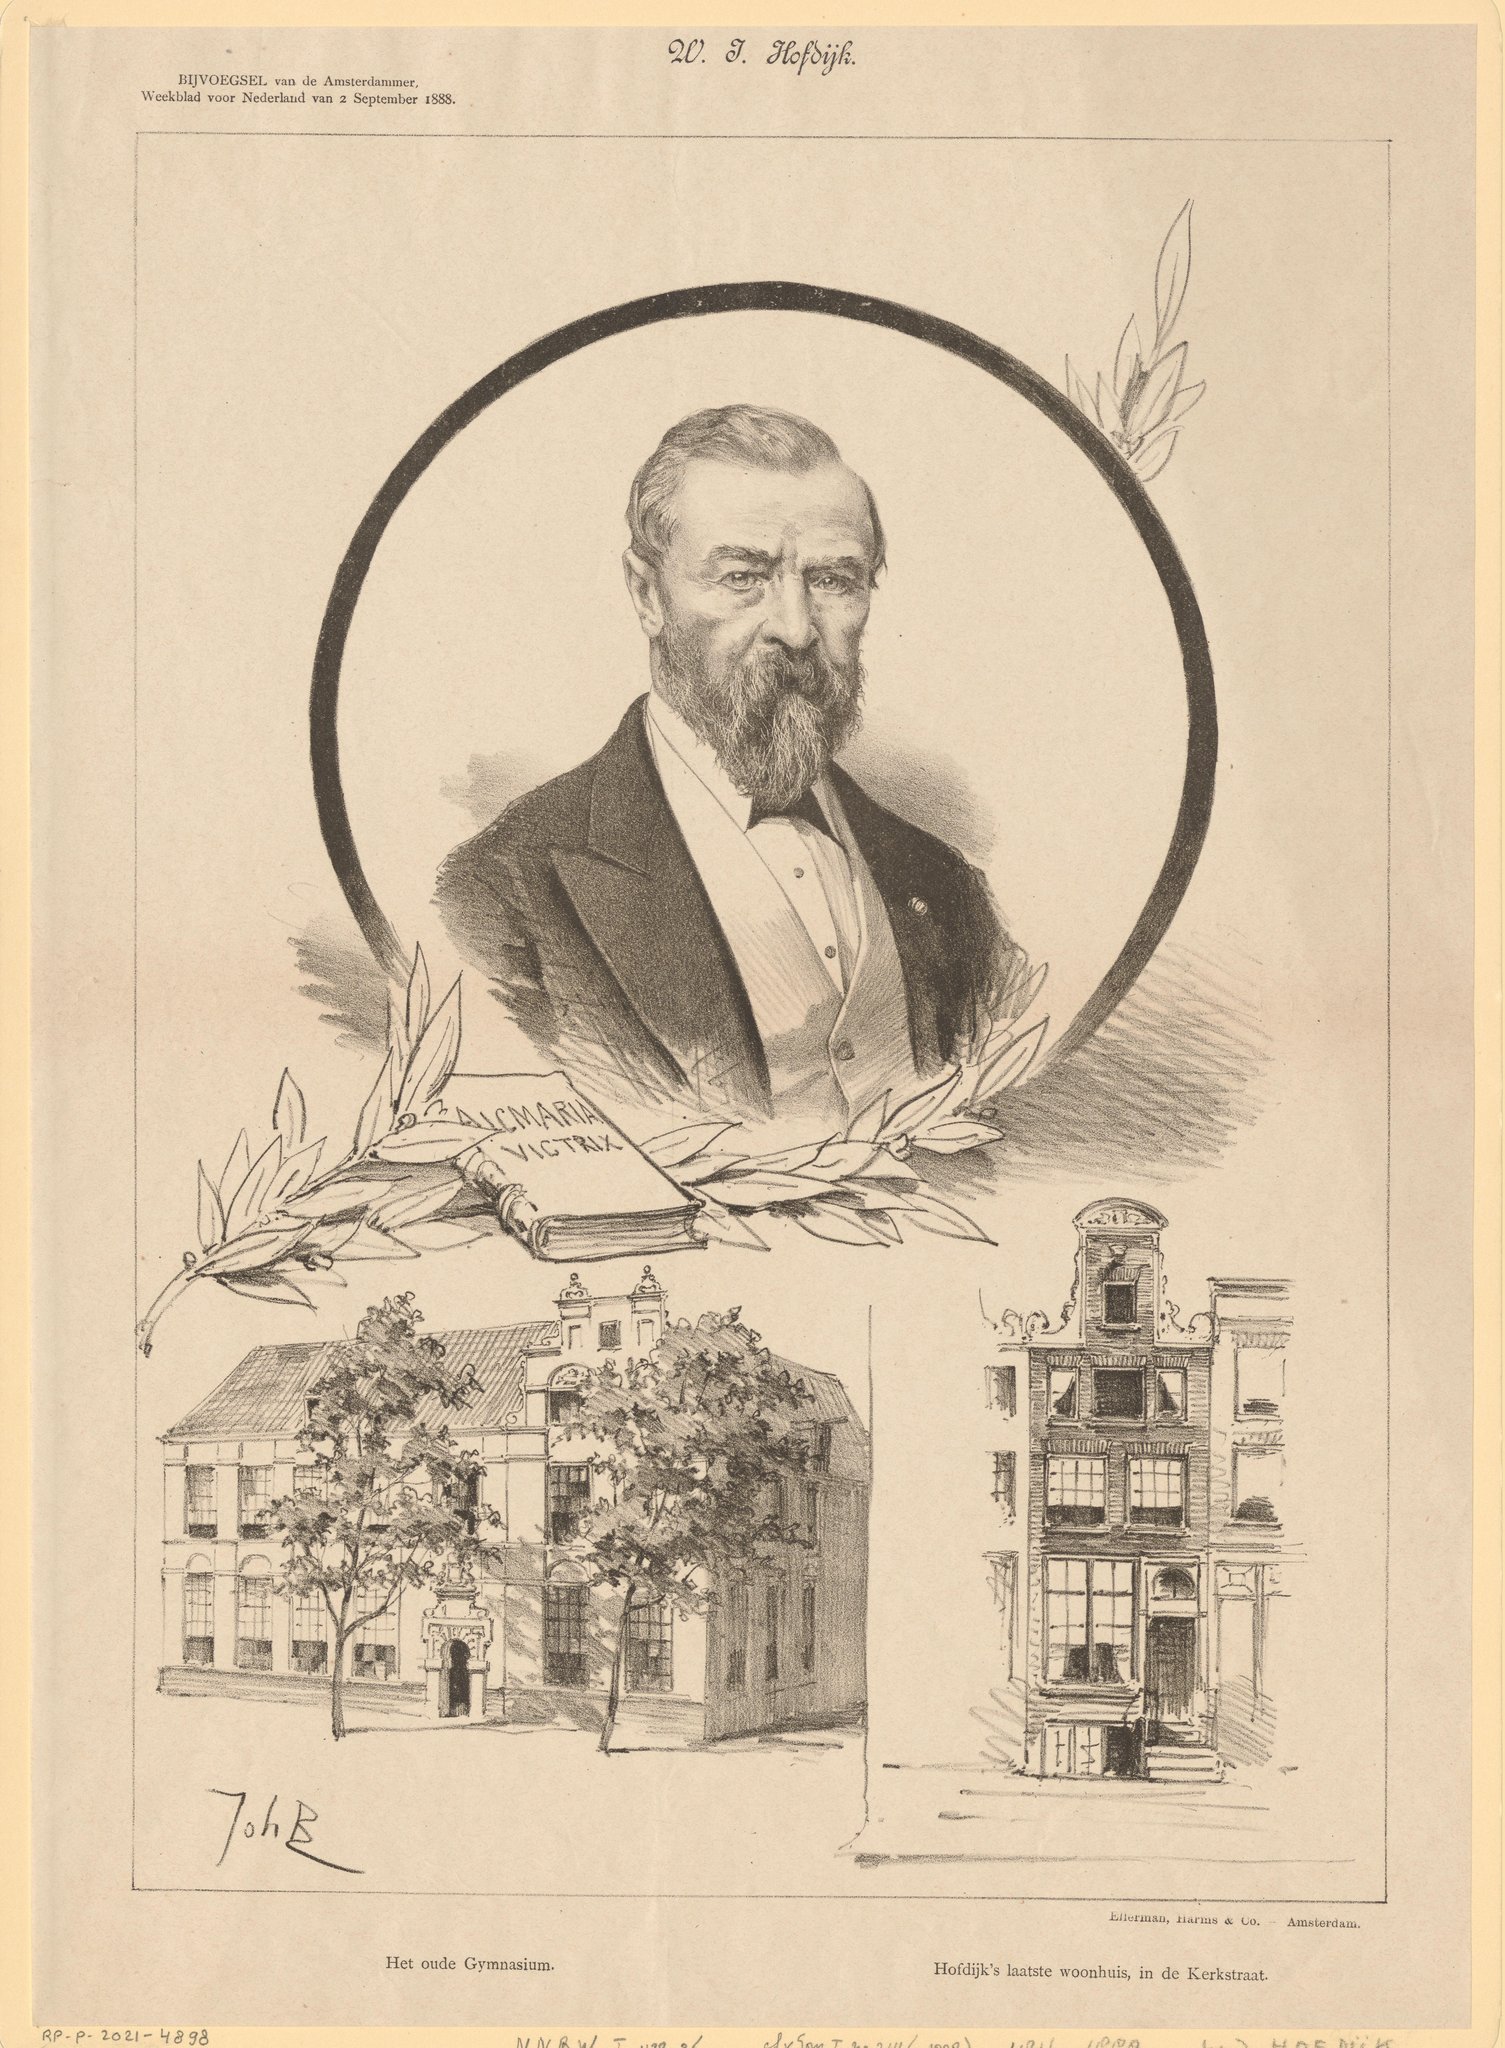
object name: print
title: Portret van Willem Jacobs Hofdijk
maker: johan braakensiek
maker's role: draughtsman, print maker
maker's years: 1858-1940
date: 1888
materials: paper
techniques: lithograph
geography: amsterdam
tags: historical persons, book, writer, poet, author, civic architecture; edifices; dwellings, amsterdam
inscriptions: date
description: Met onder het portret het voormalig Stedelijk Gymnasium aan het Singel en Hofdijks laatste woonhuis in de Kerkstraat, beide in Amsterdam.